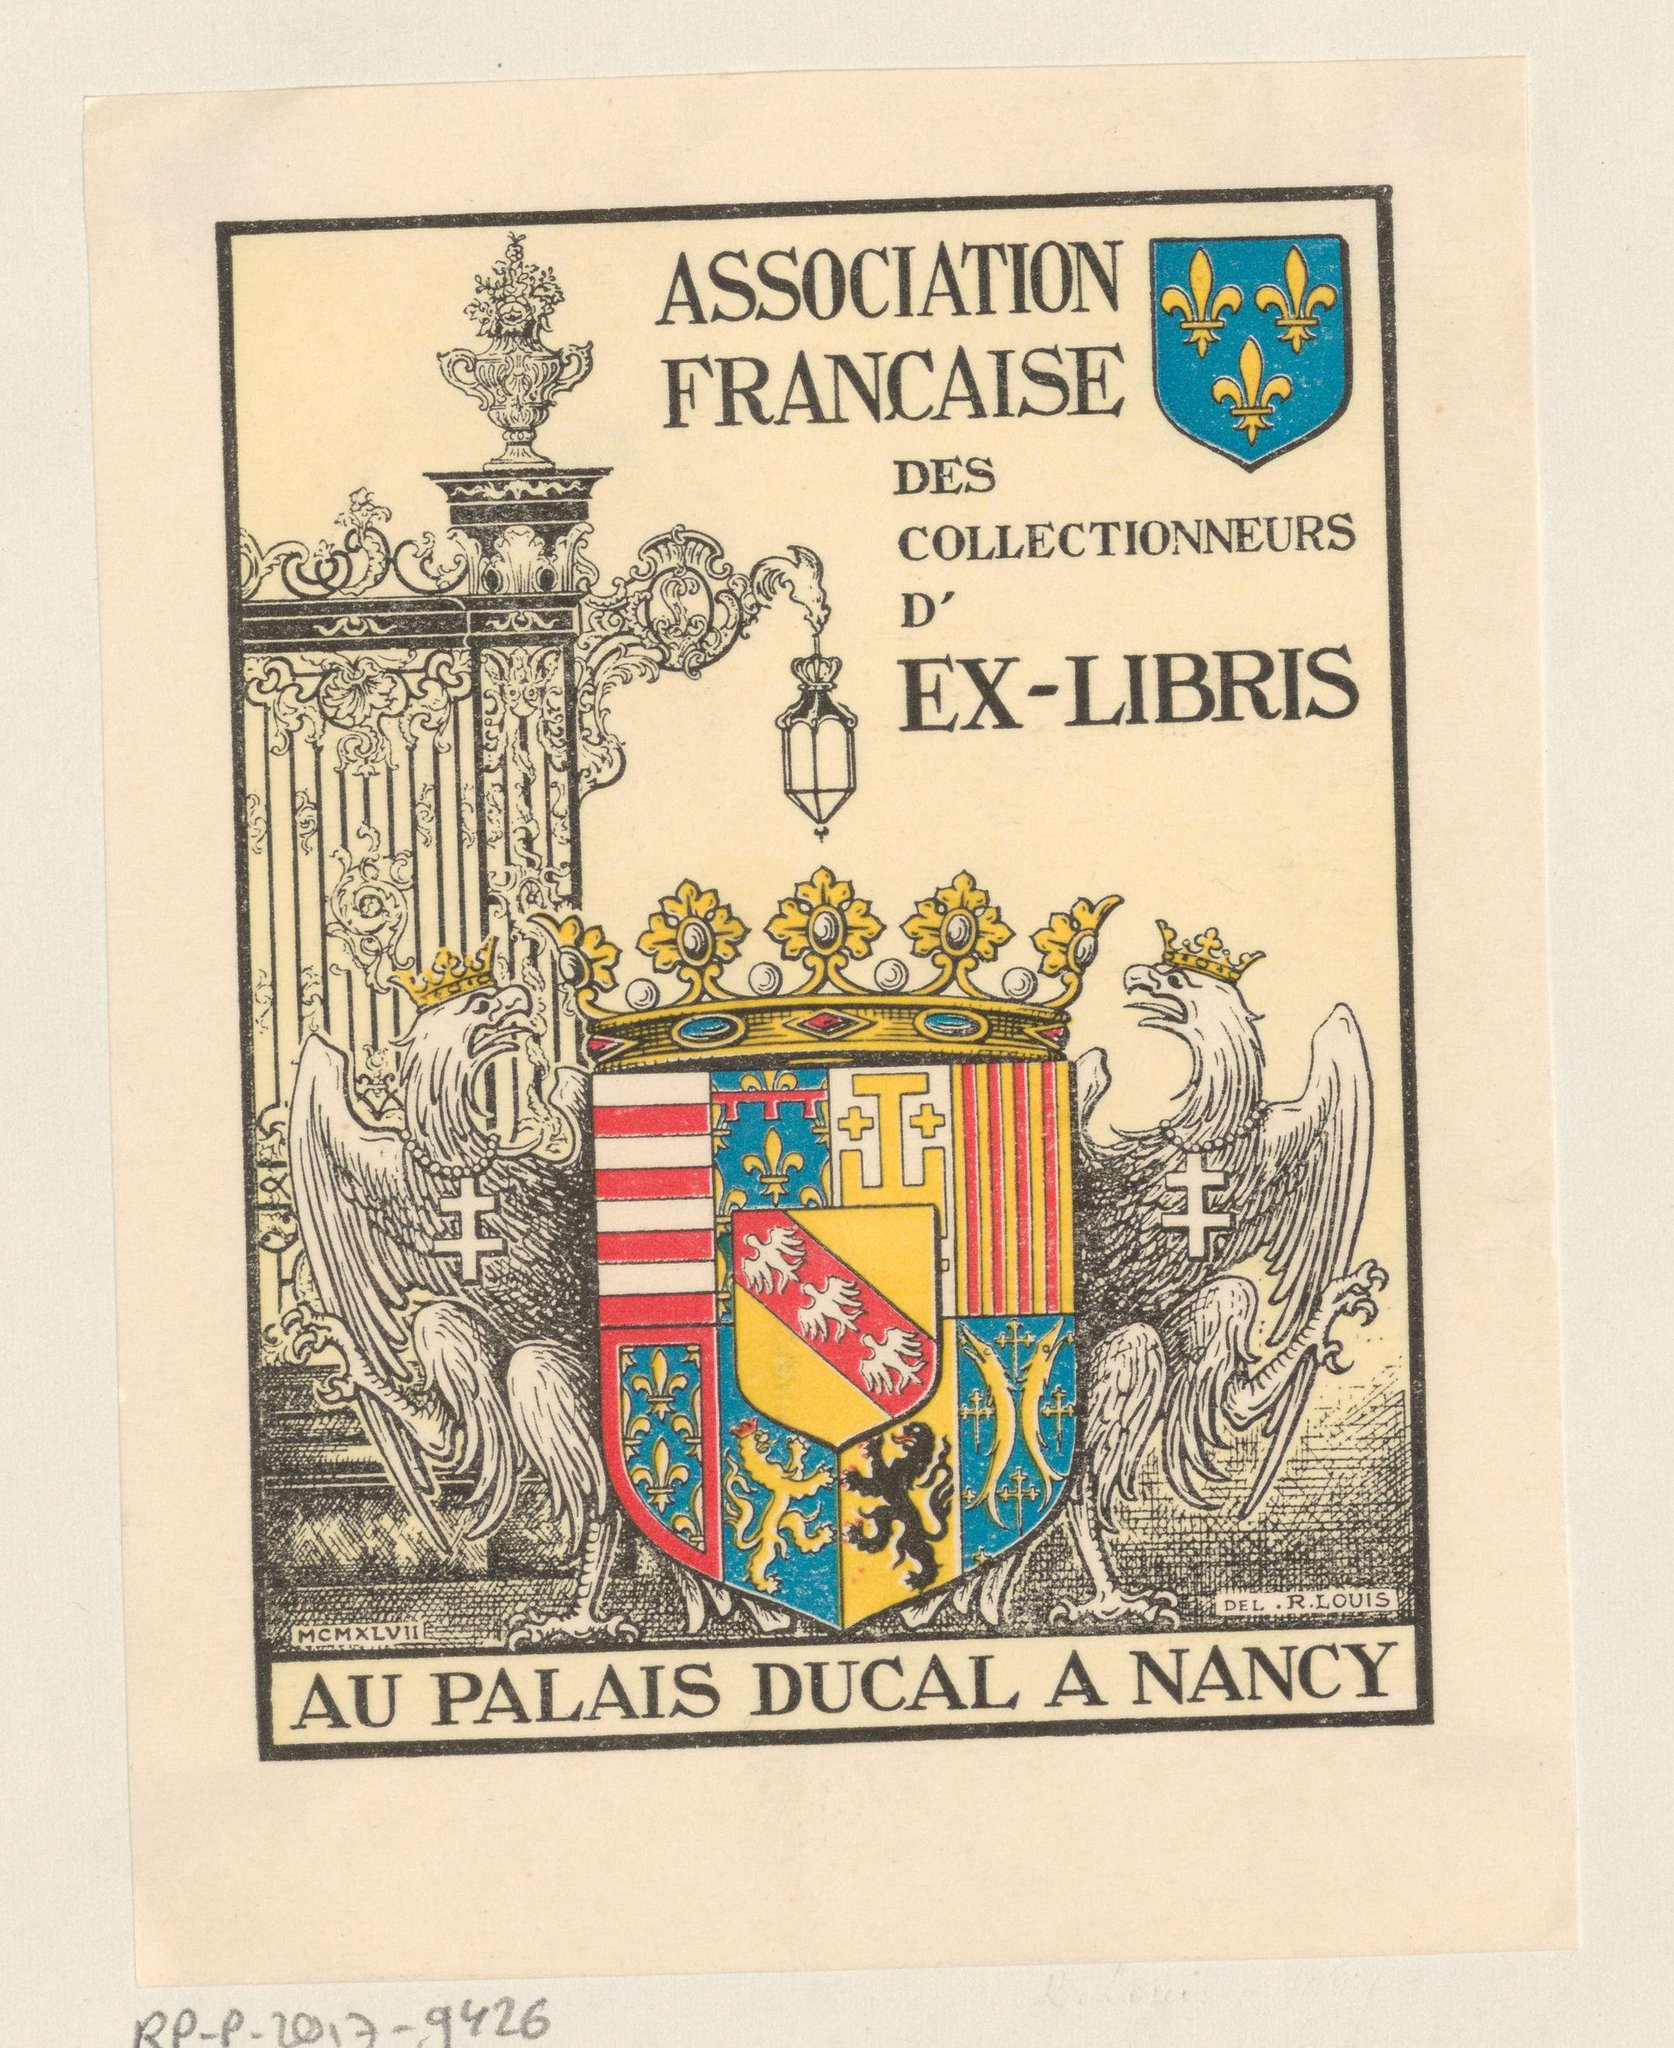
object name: bookplate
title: Association Française des collectionneurs d'ex-libris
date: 1947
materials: paper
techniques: printing block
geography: france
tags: riding a horse, ass, or mule; rider, horseman, predatory birds: eagle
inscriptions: date